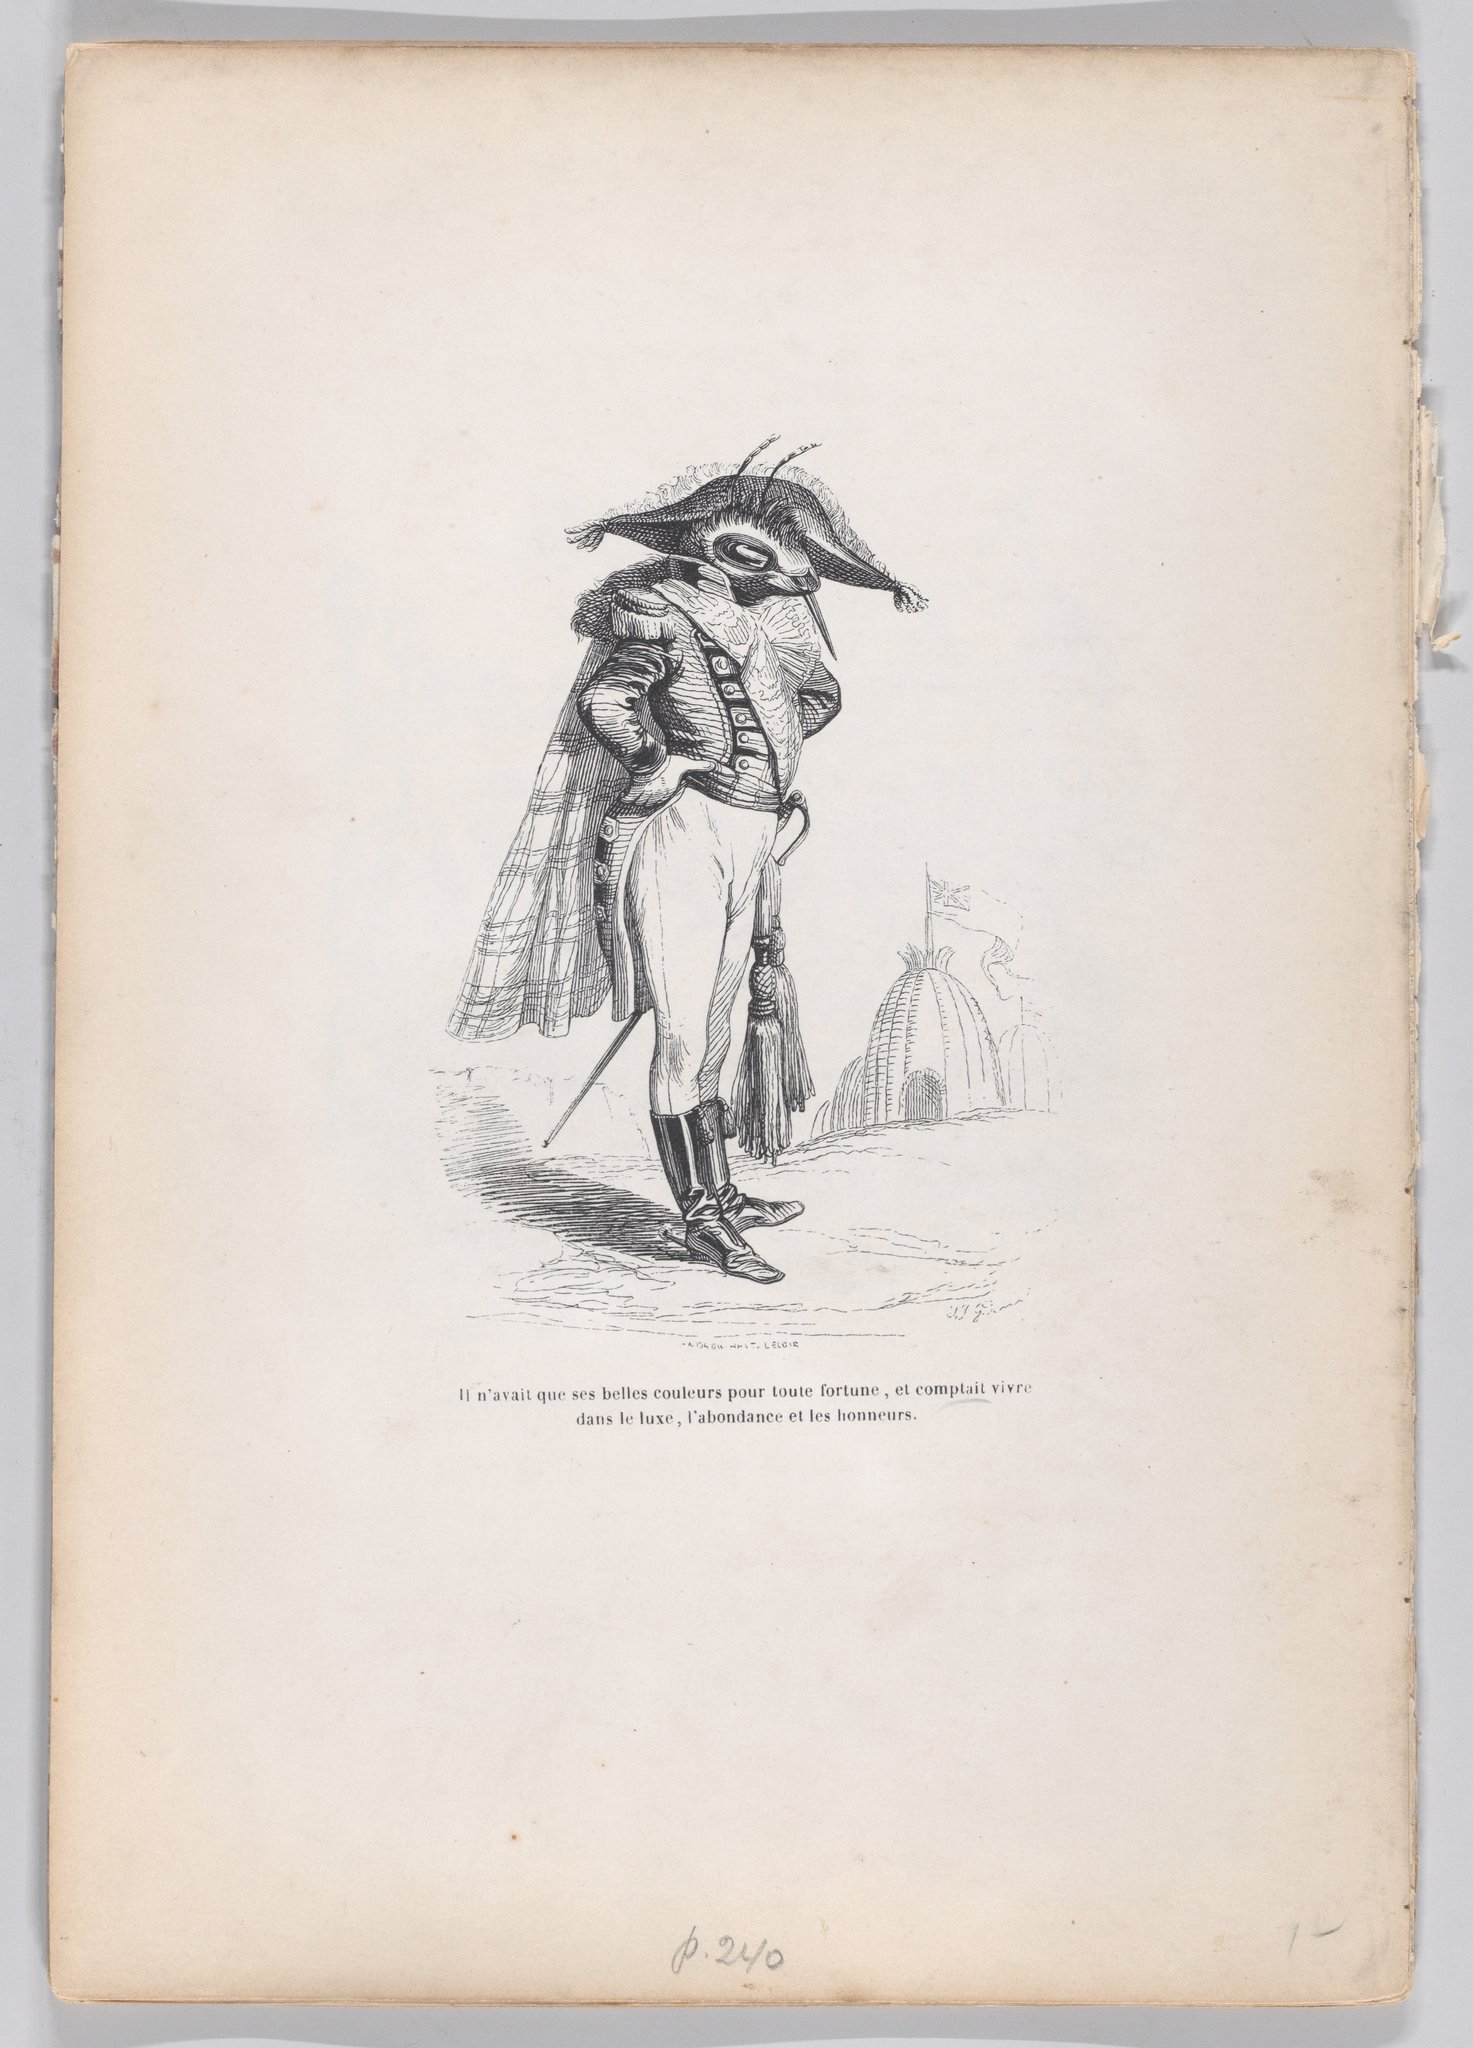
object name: print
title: He had only his beautiful colors..., from "Scenes from the Private and Public Life of Animals"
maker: j. j. grandville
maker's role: illustrator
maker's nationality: french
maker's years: 1803-1847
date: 1837-1847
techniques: engraving